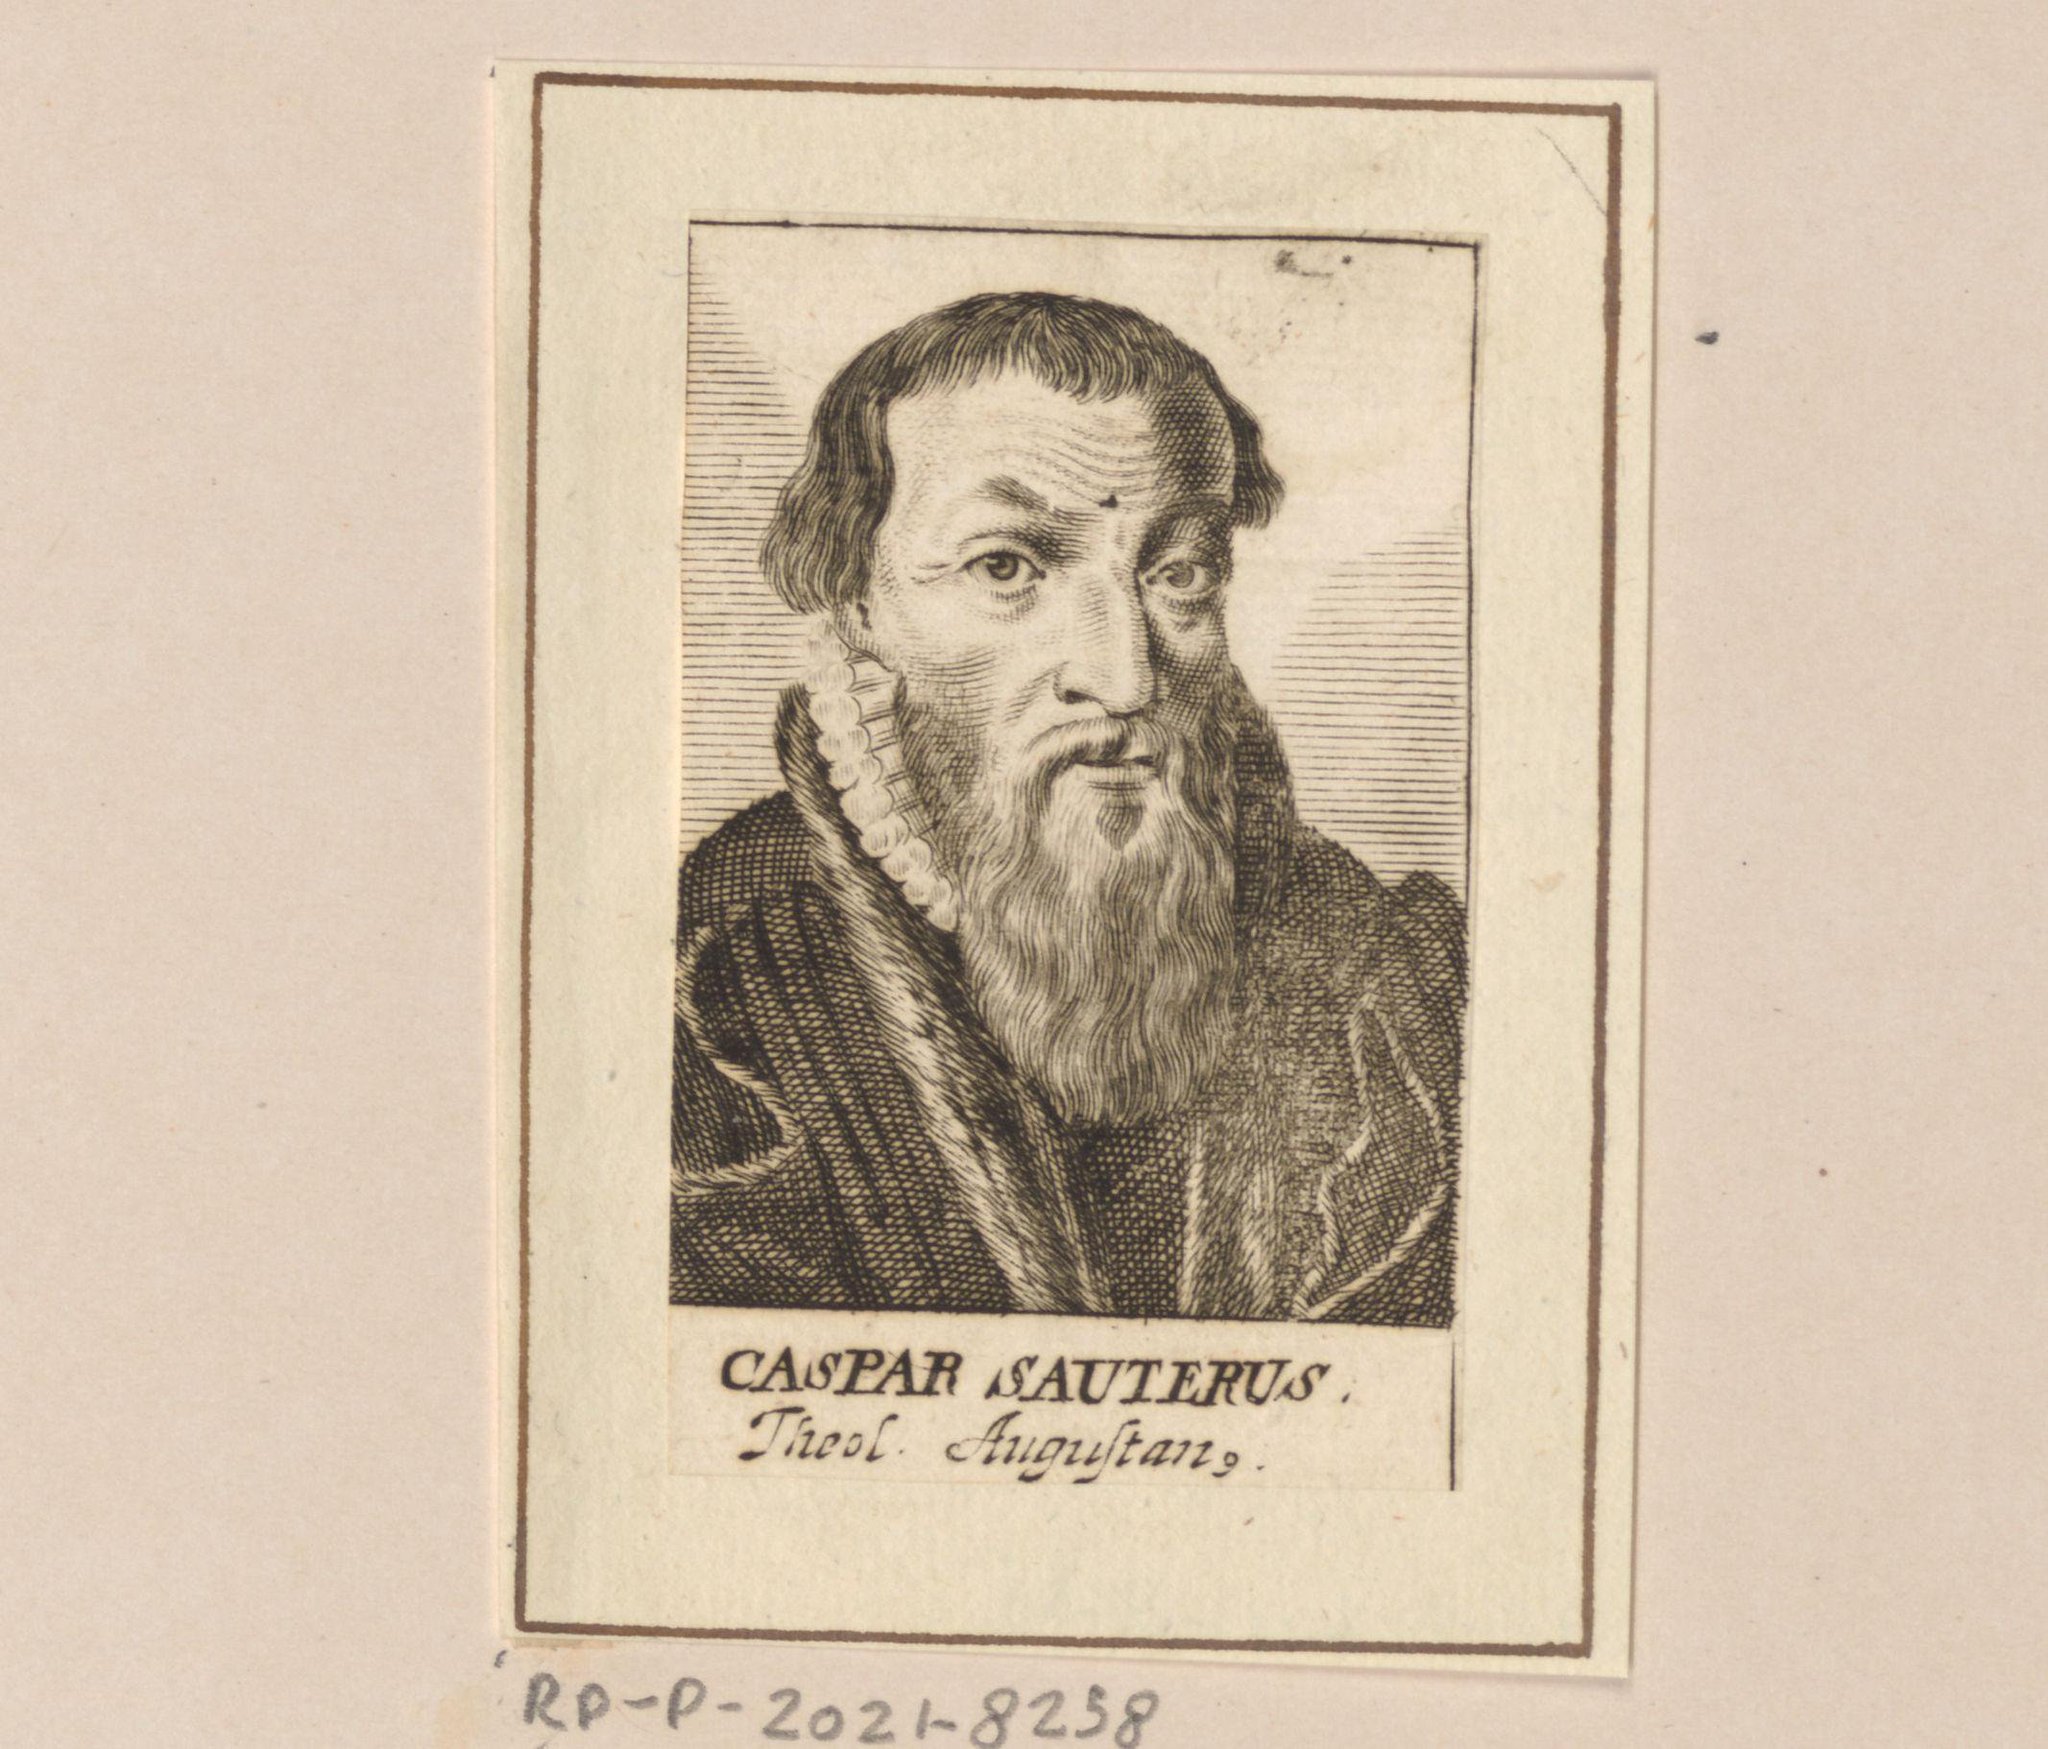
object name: print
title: Portret van Kaspar Sautter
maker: Anonymous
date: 1688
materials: paper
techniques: engraving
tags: archbishop, bishop, etc. (roman catholic), historical persons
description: Prent maakt deel uit van een grotere prent die later is verknipt. Prent waarschijnlijk uit: Freher, Paul. Theatrum virorum eruditione clarorum. Neurenberg: Johann Hoffmann, 1688.